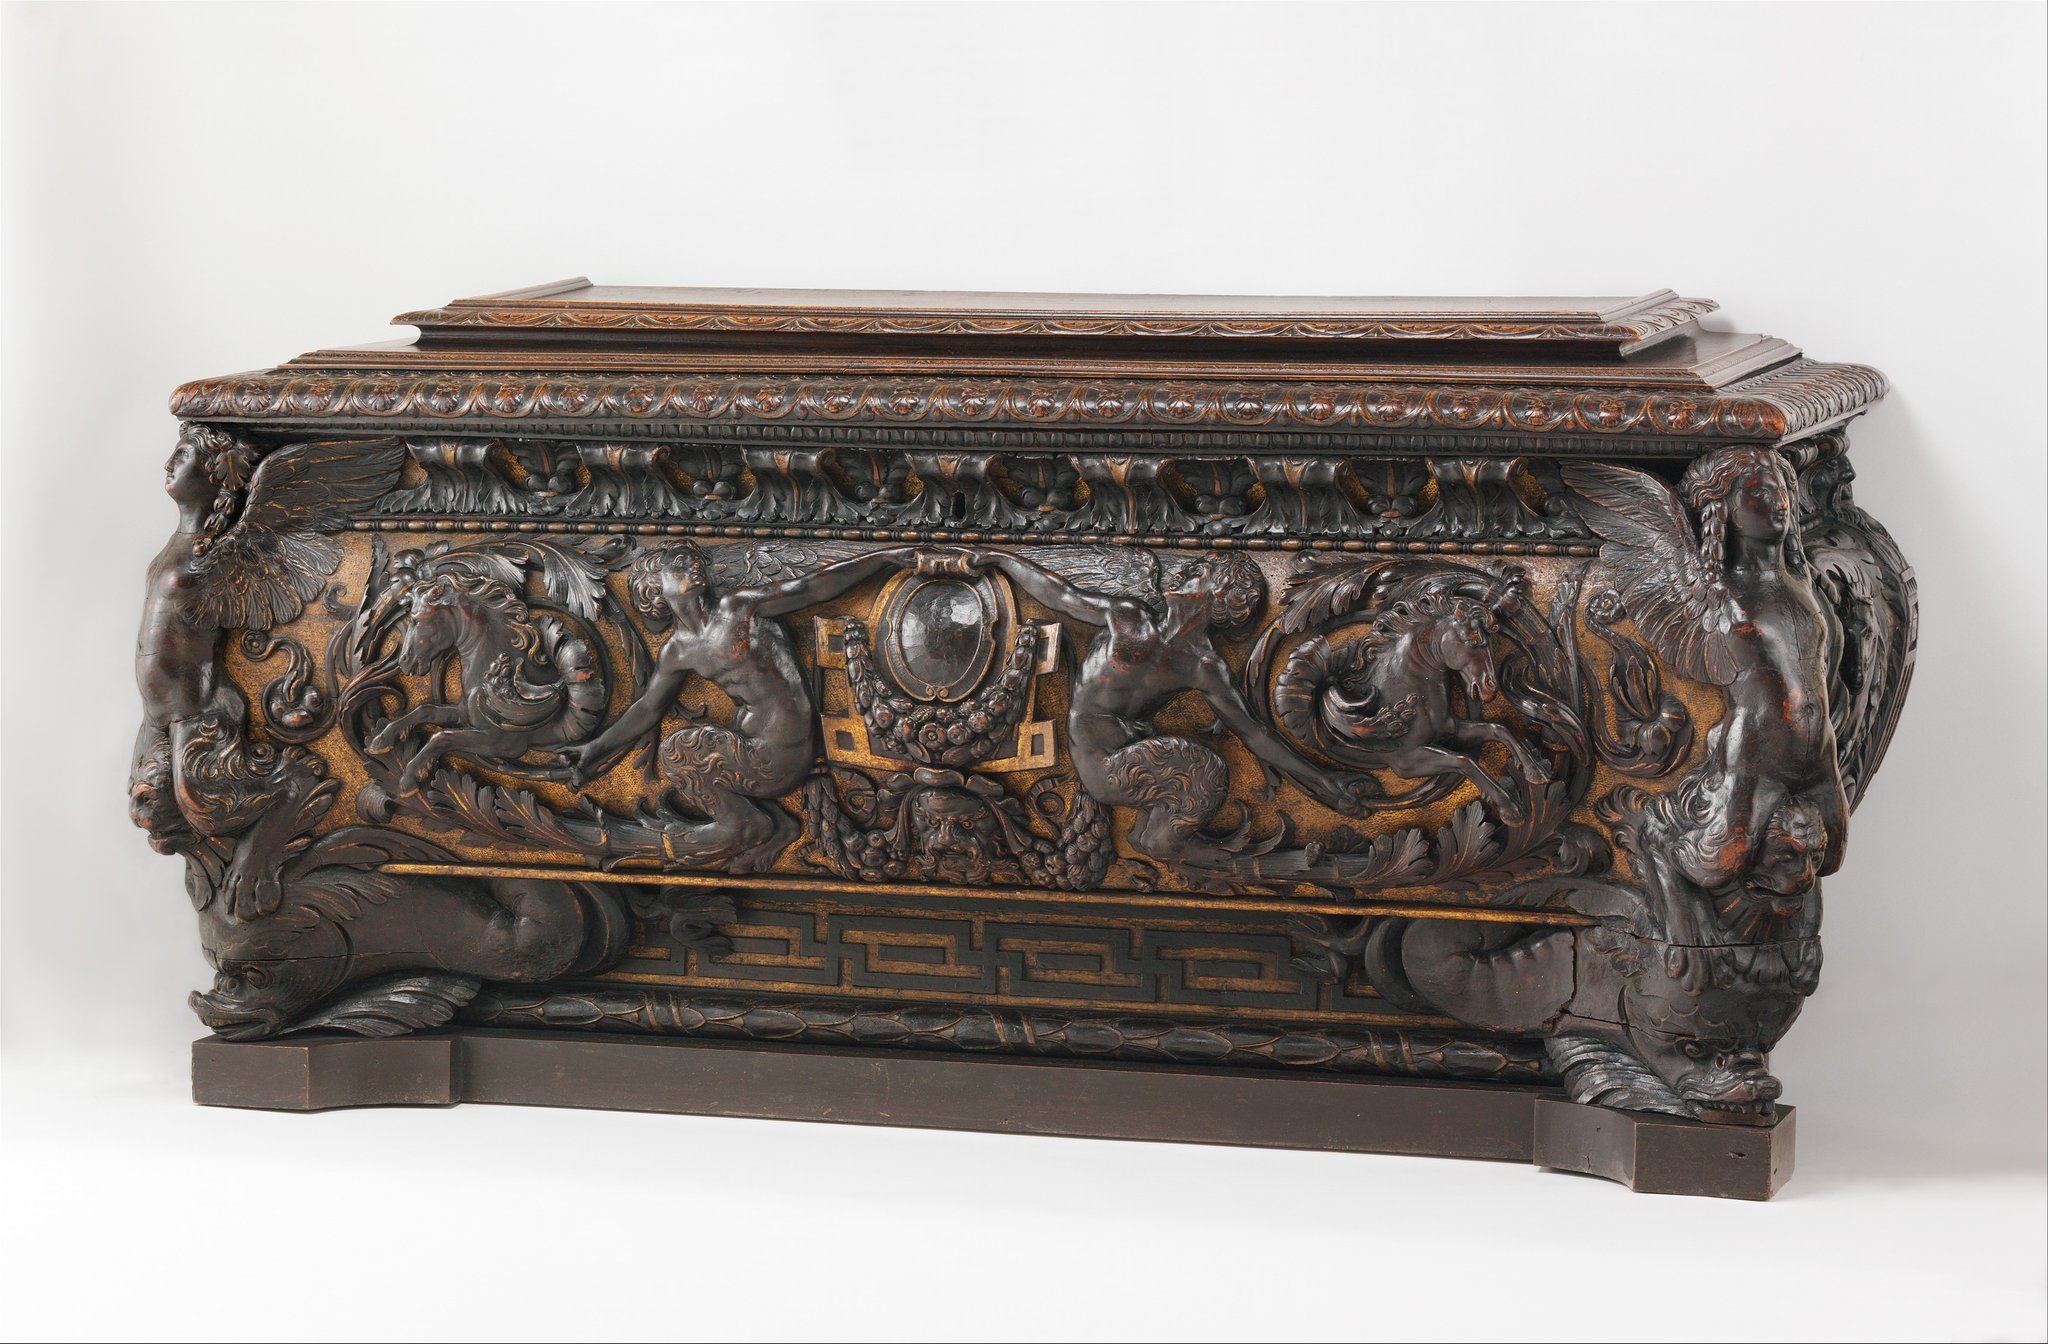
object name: cassone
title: Cassone (one of a pair)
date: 1550-1560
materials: wood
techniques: carving, gilding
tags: satyrs,horses